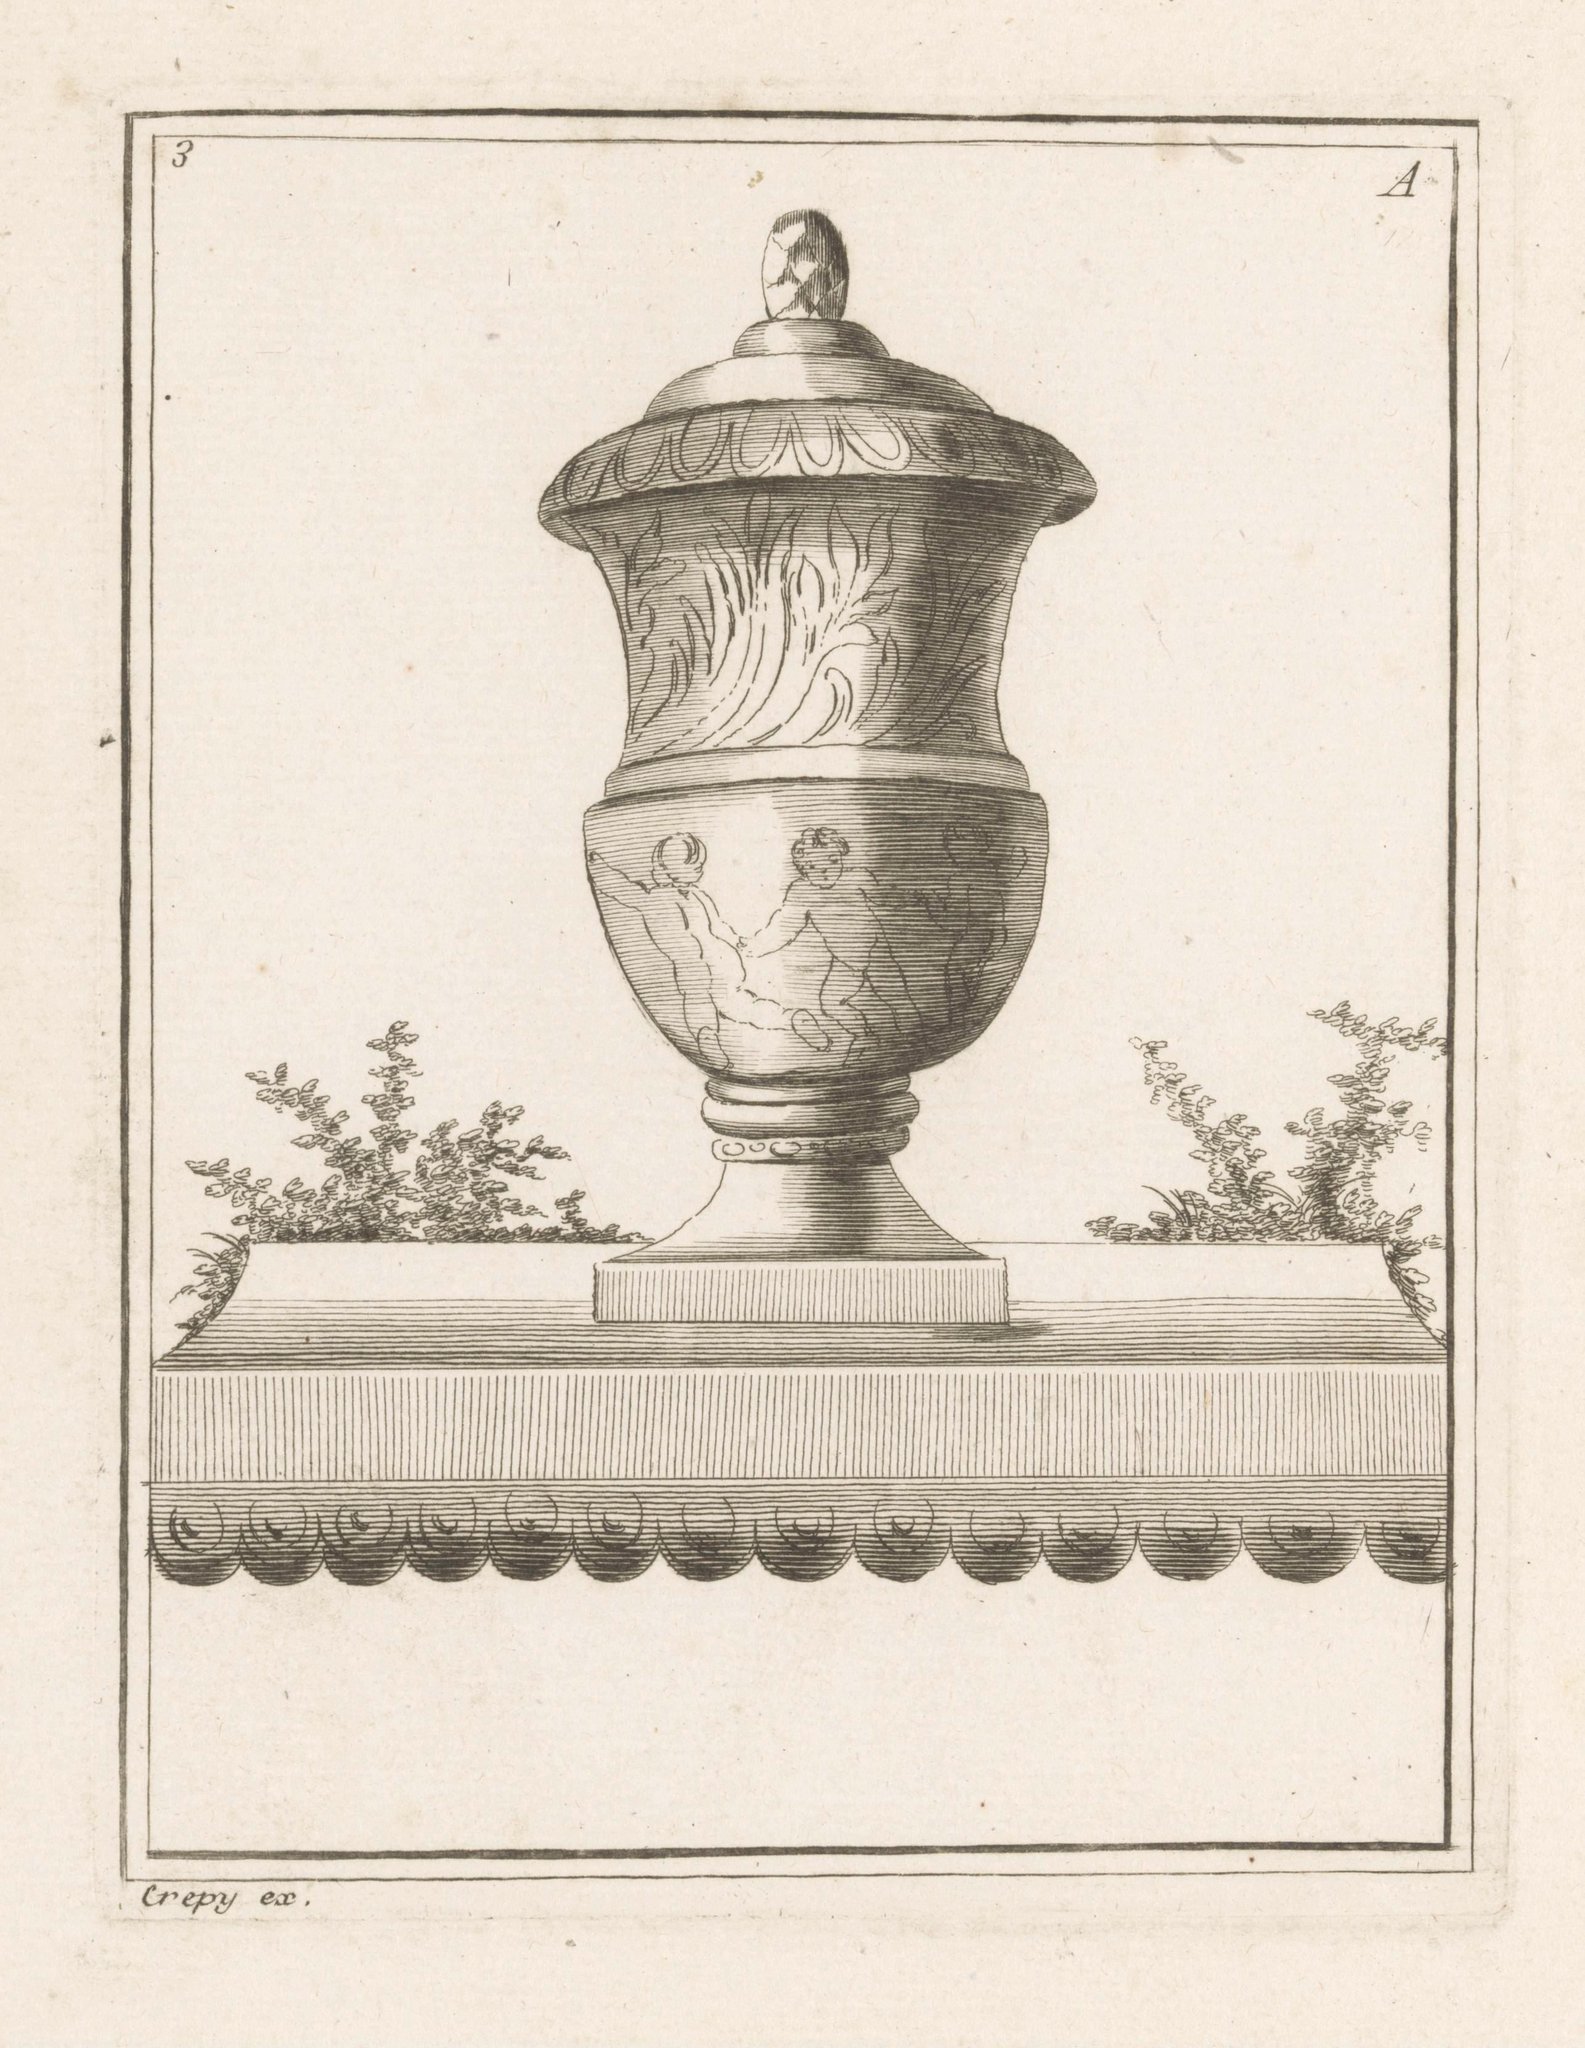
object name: print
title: Vaas met spelende kinderen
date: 1770-1780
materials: paper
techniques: etching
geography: paris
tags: children's games and plays, vase ~ ornament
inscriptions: collector's mark: Lugt 2760, collector's mark: Lugt 2228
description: Een geornamenteerde vaas met bladmotieven en spelende kinderen. Rechts boven A genummerd.